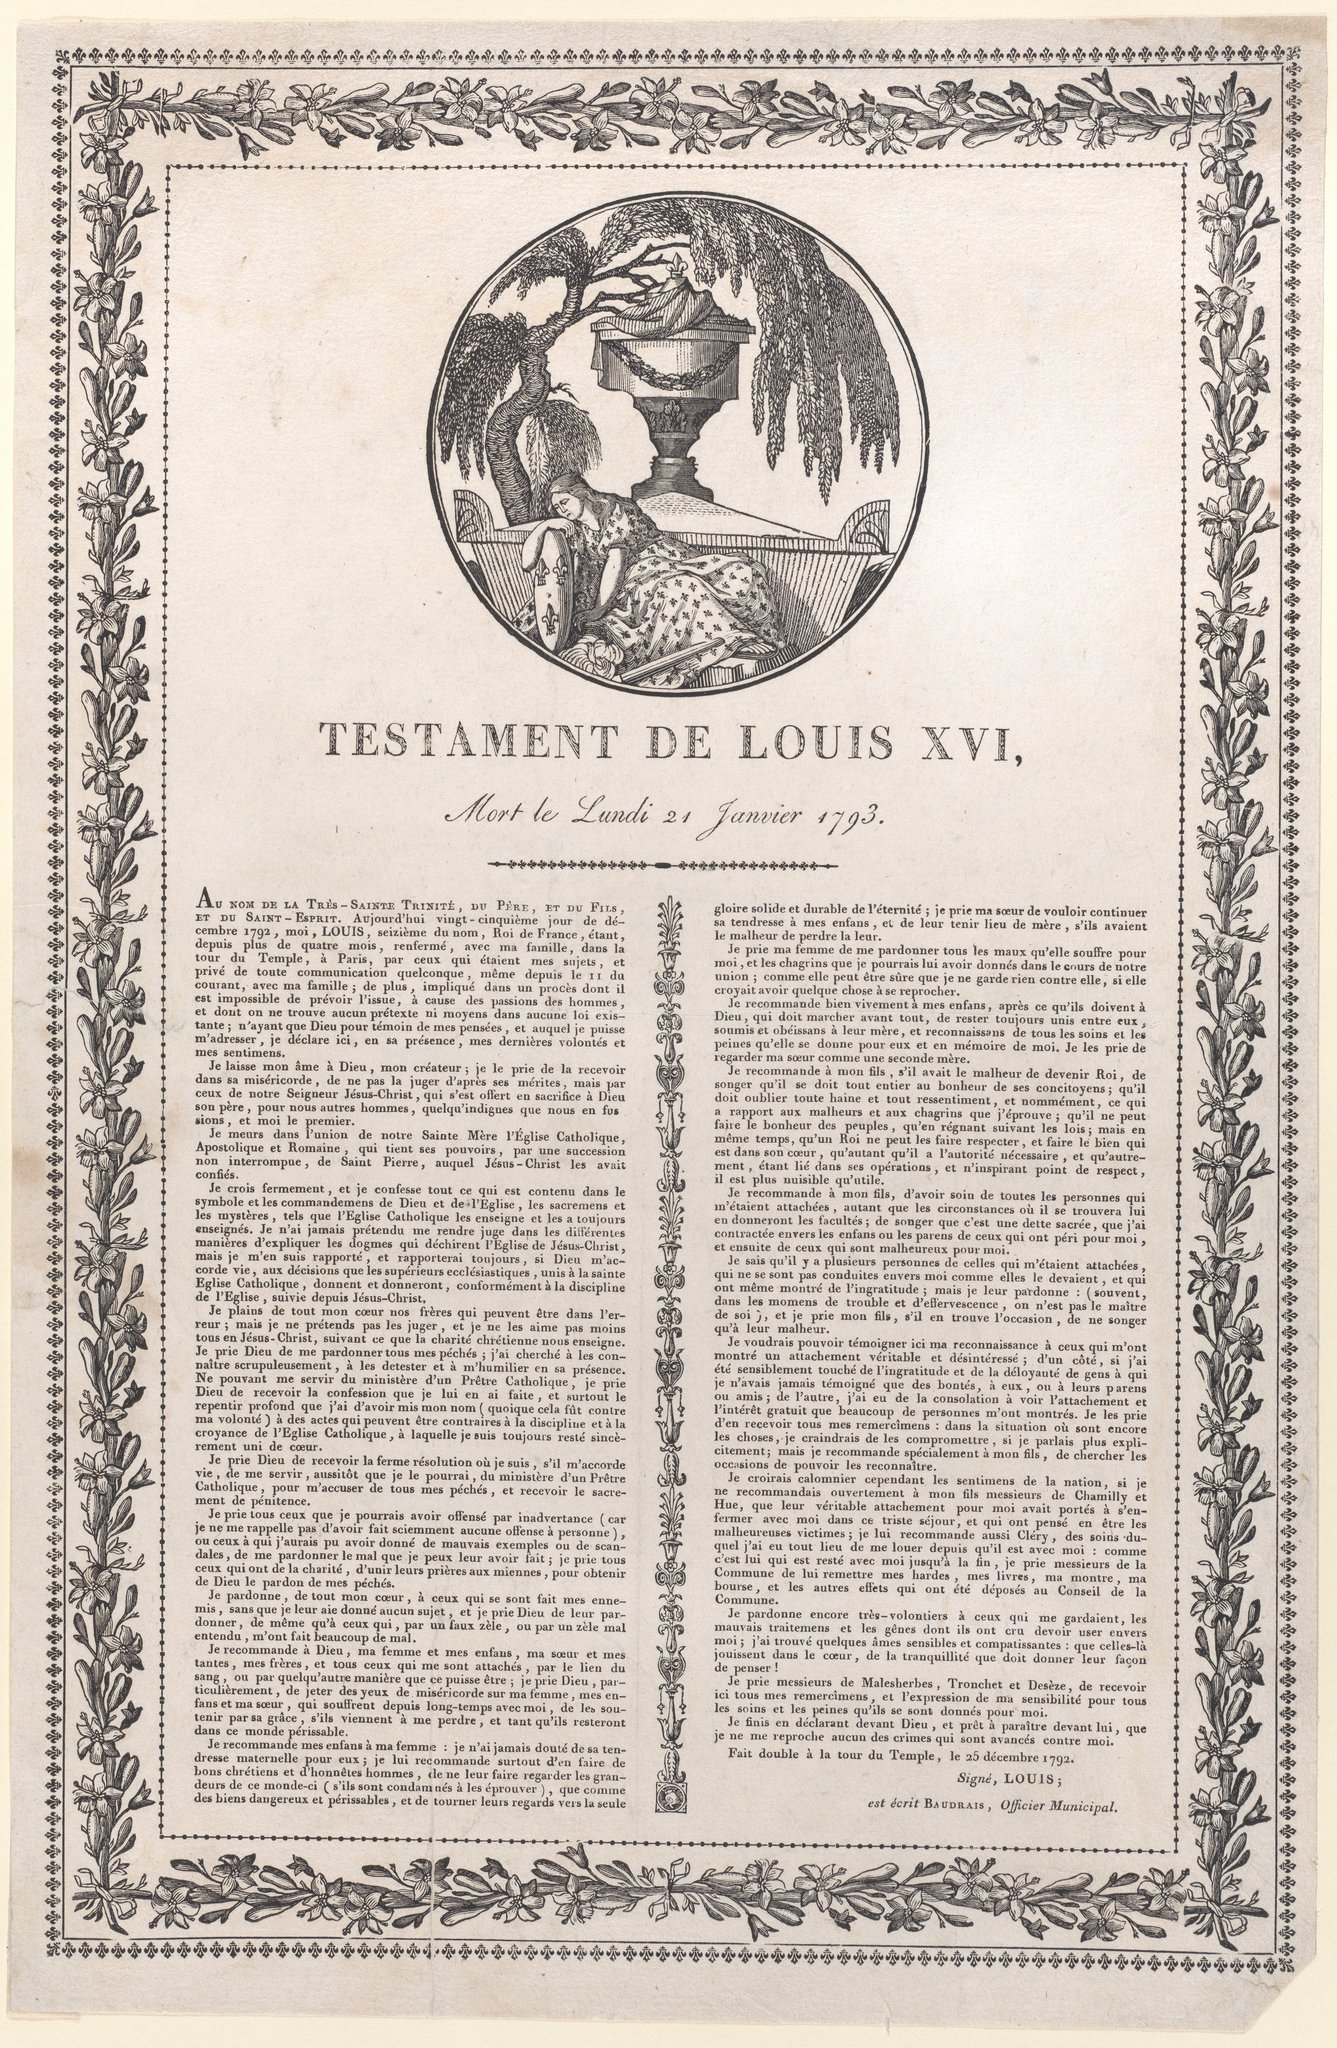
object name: print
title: The last words of Louis XVI (Testament de Louis XVI)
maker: Anonymous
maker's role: artist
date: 1793-1800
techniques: engraving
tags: french revolution,kings,louis xvi,marie antoinette,queens